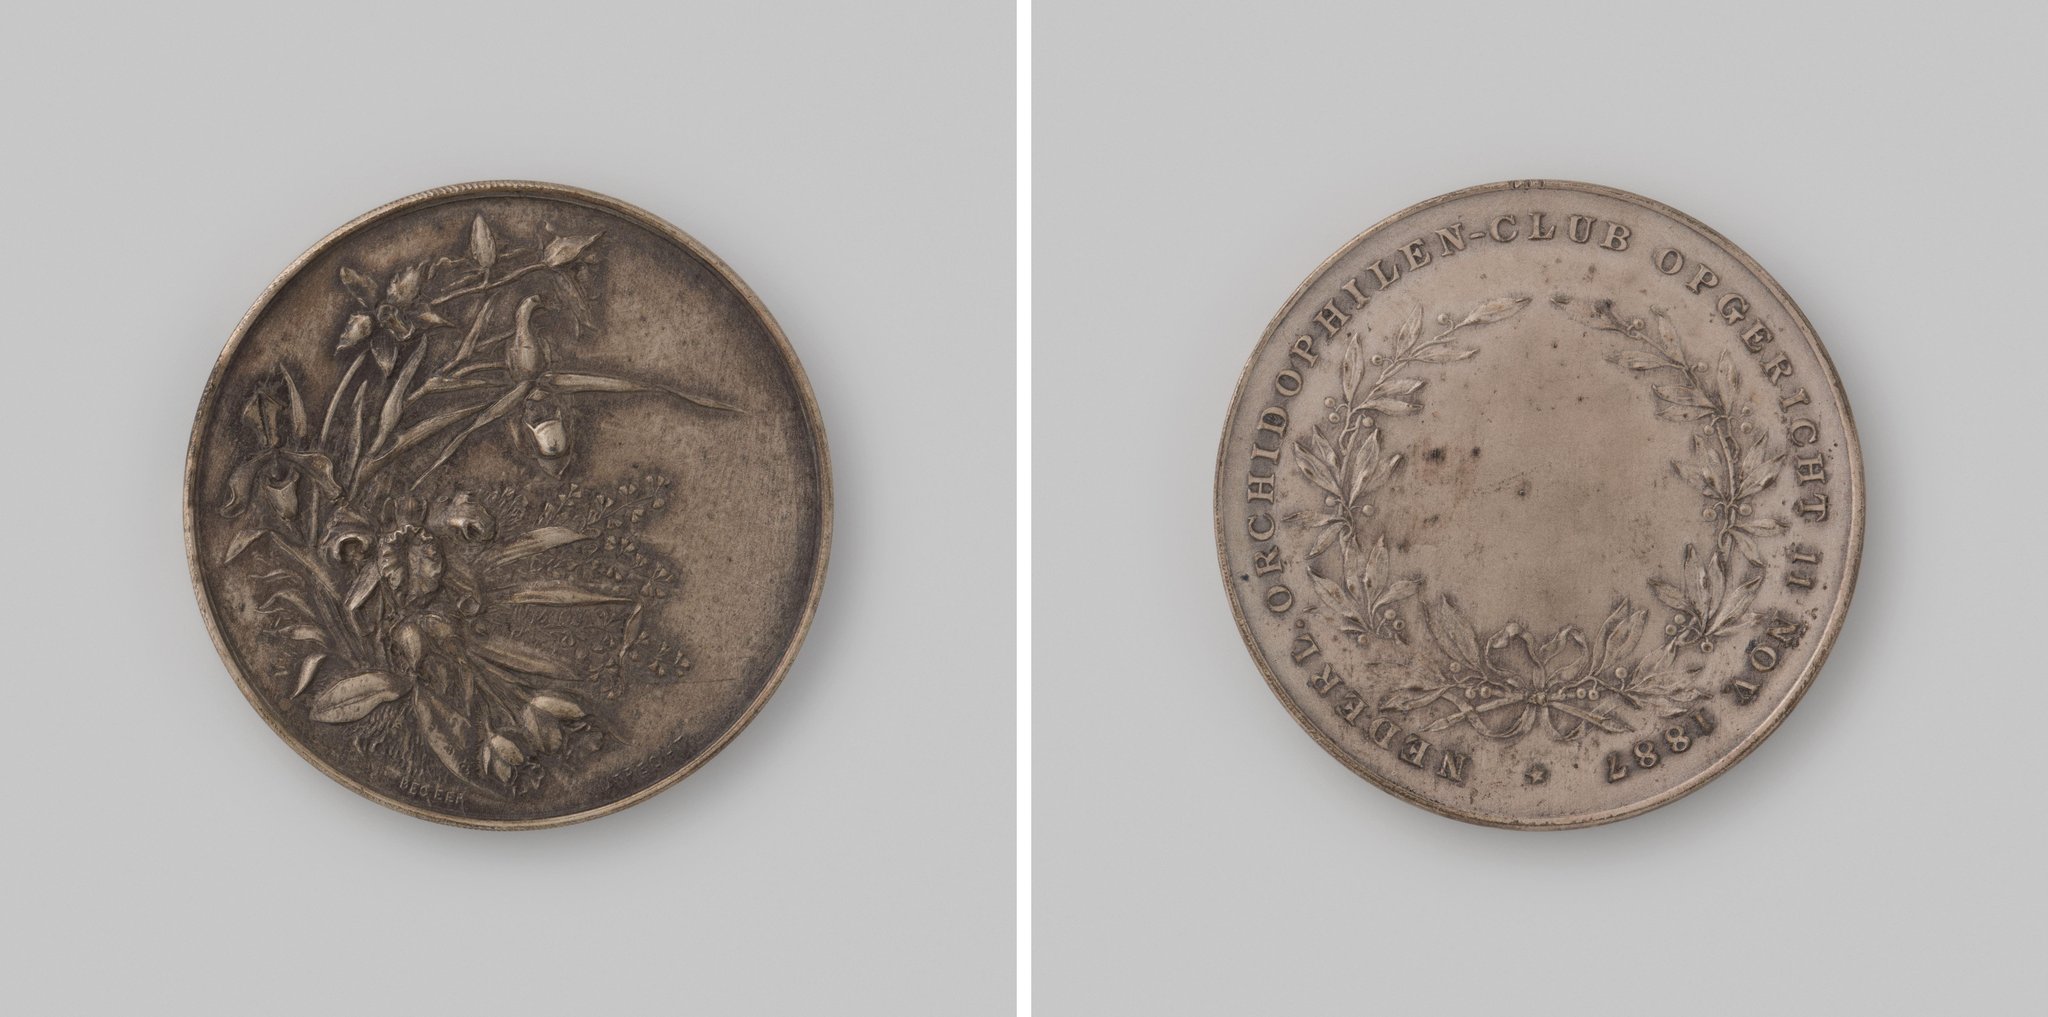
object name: medal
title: Prijspenning van de Nederlandsche Orchidophilen-Club te Amsterdam (1887)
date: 1887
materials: brass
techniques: striking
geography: utrecht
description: Verzilverde penning, op de voorzijde een verzameling orchideën, op de keerzijde een inscriptieruimte tussen samengestrikte lauwertakken, met omschrift.